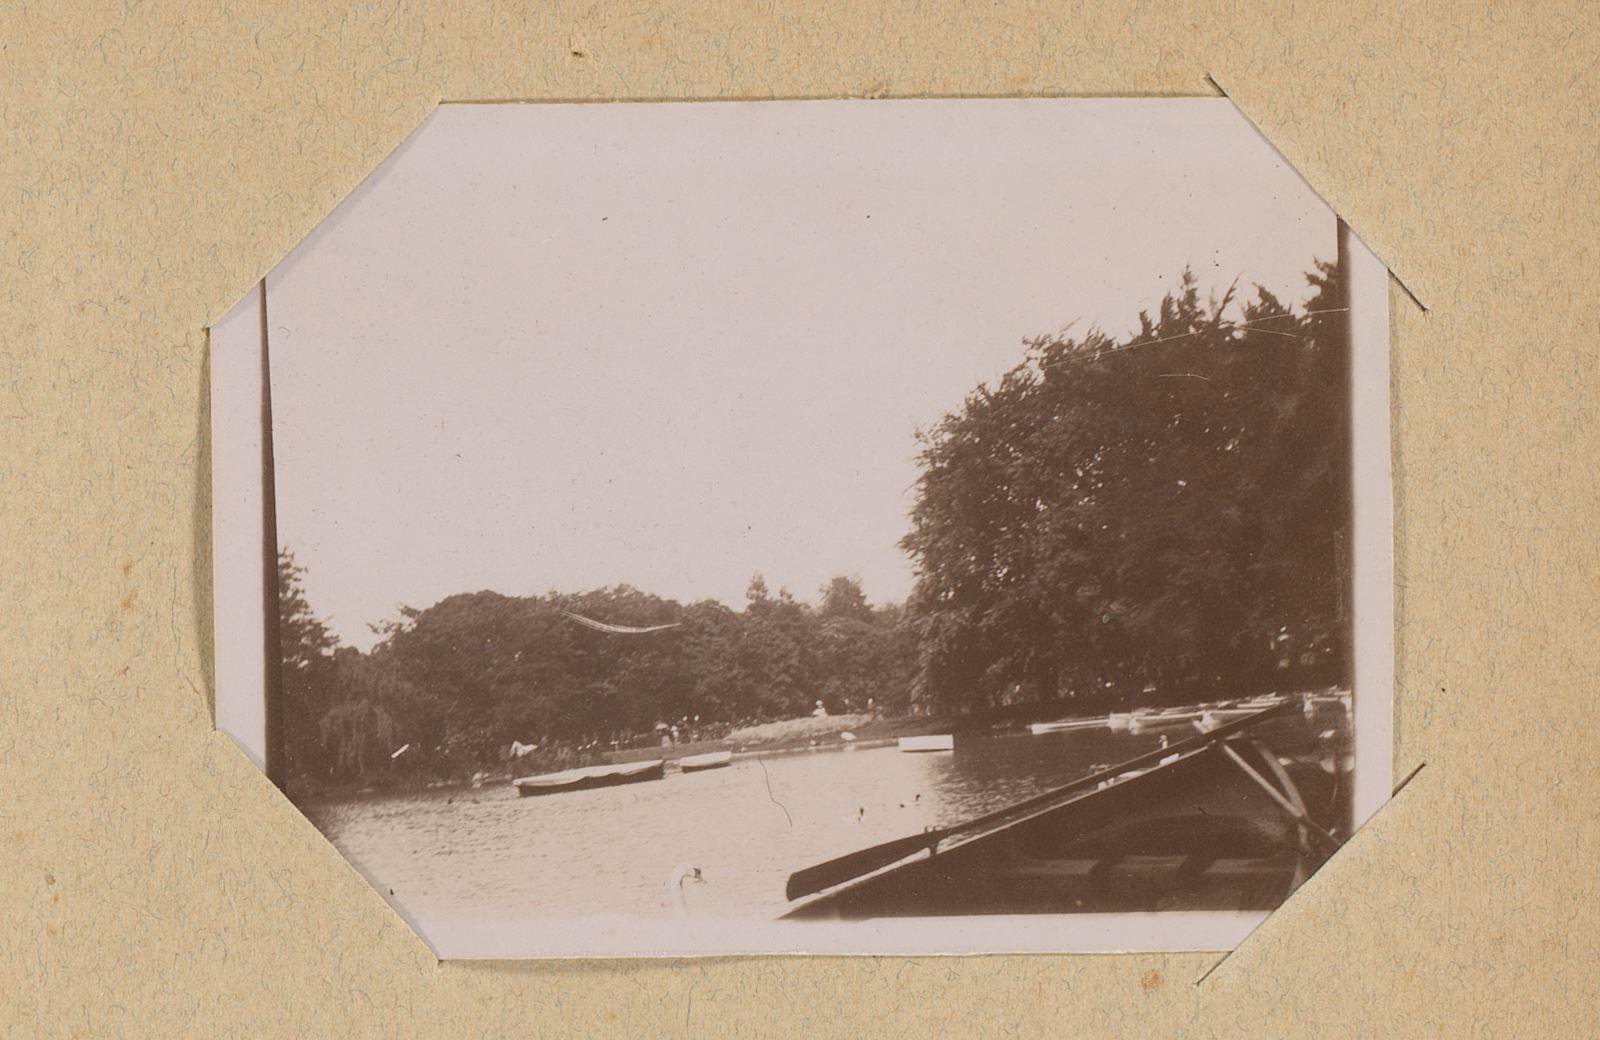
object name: photograph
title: Roeiboten op een meer in het Bois de Boulogne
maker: Anonymous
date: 1895-1900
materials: paper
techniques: gelatin silver print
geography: paris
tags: lake, rowing facing backward, pulling